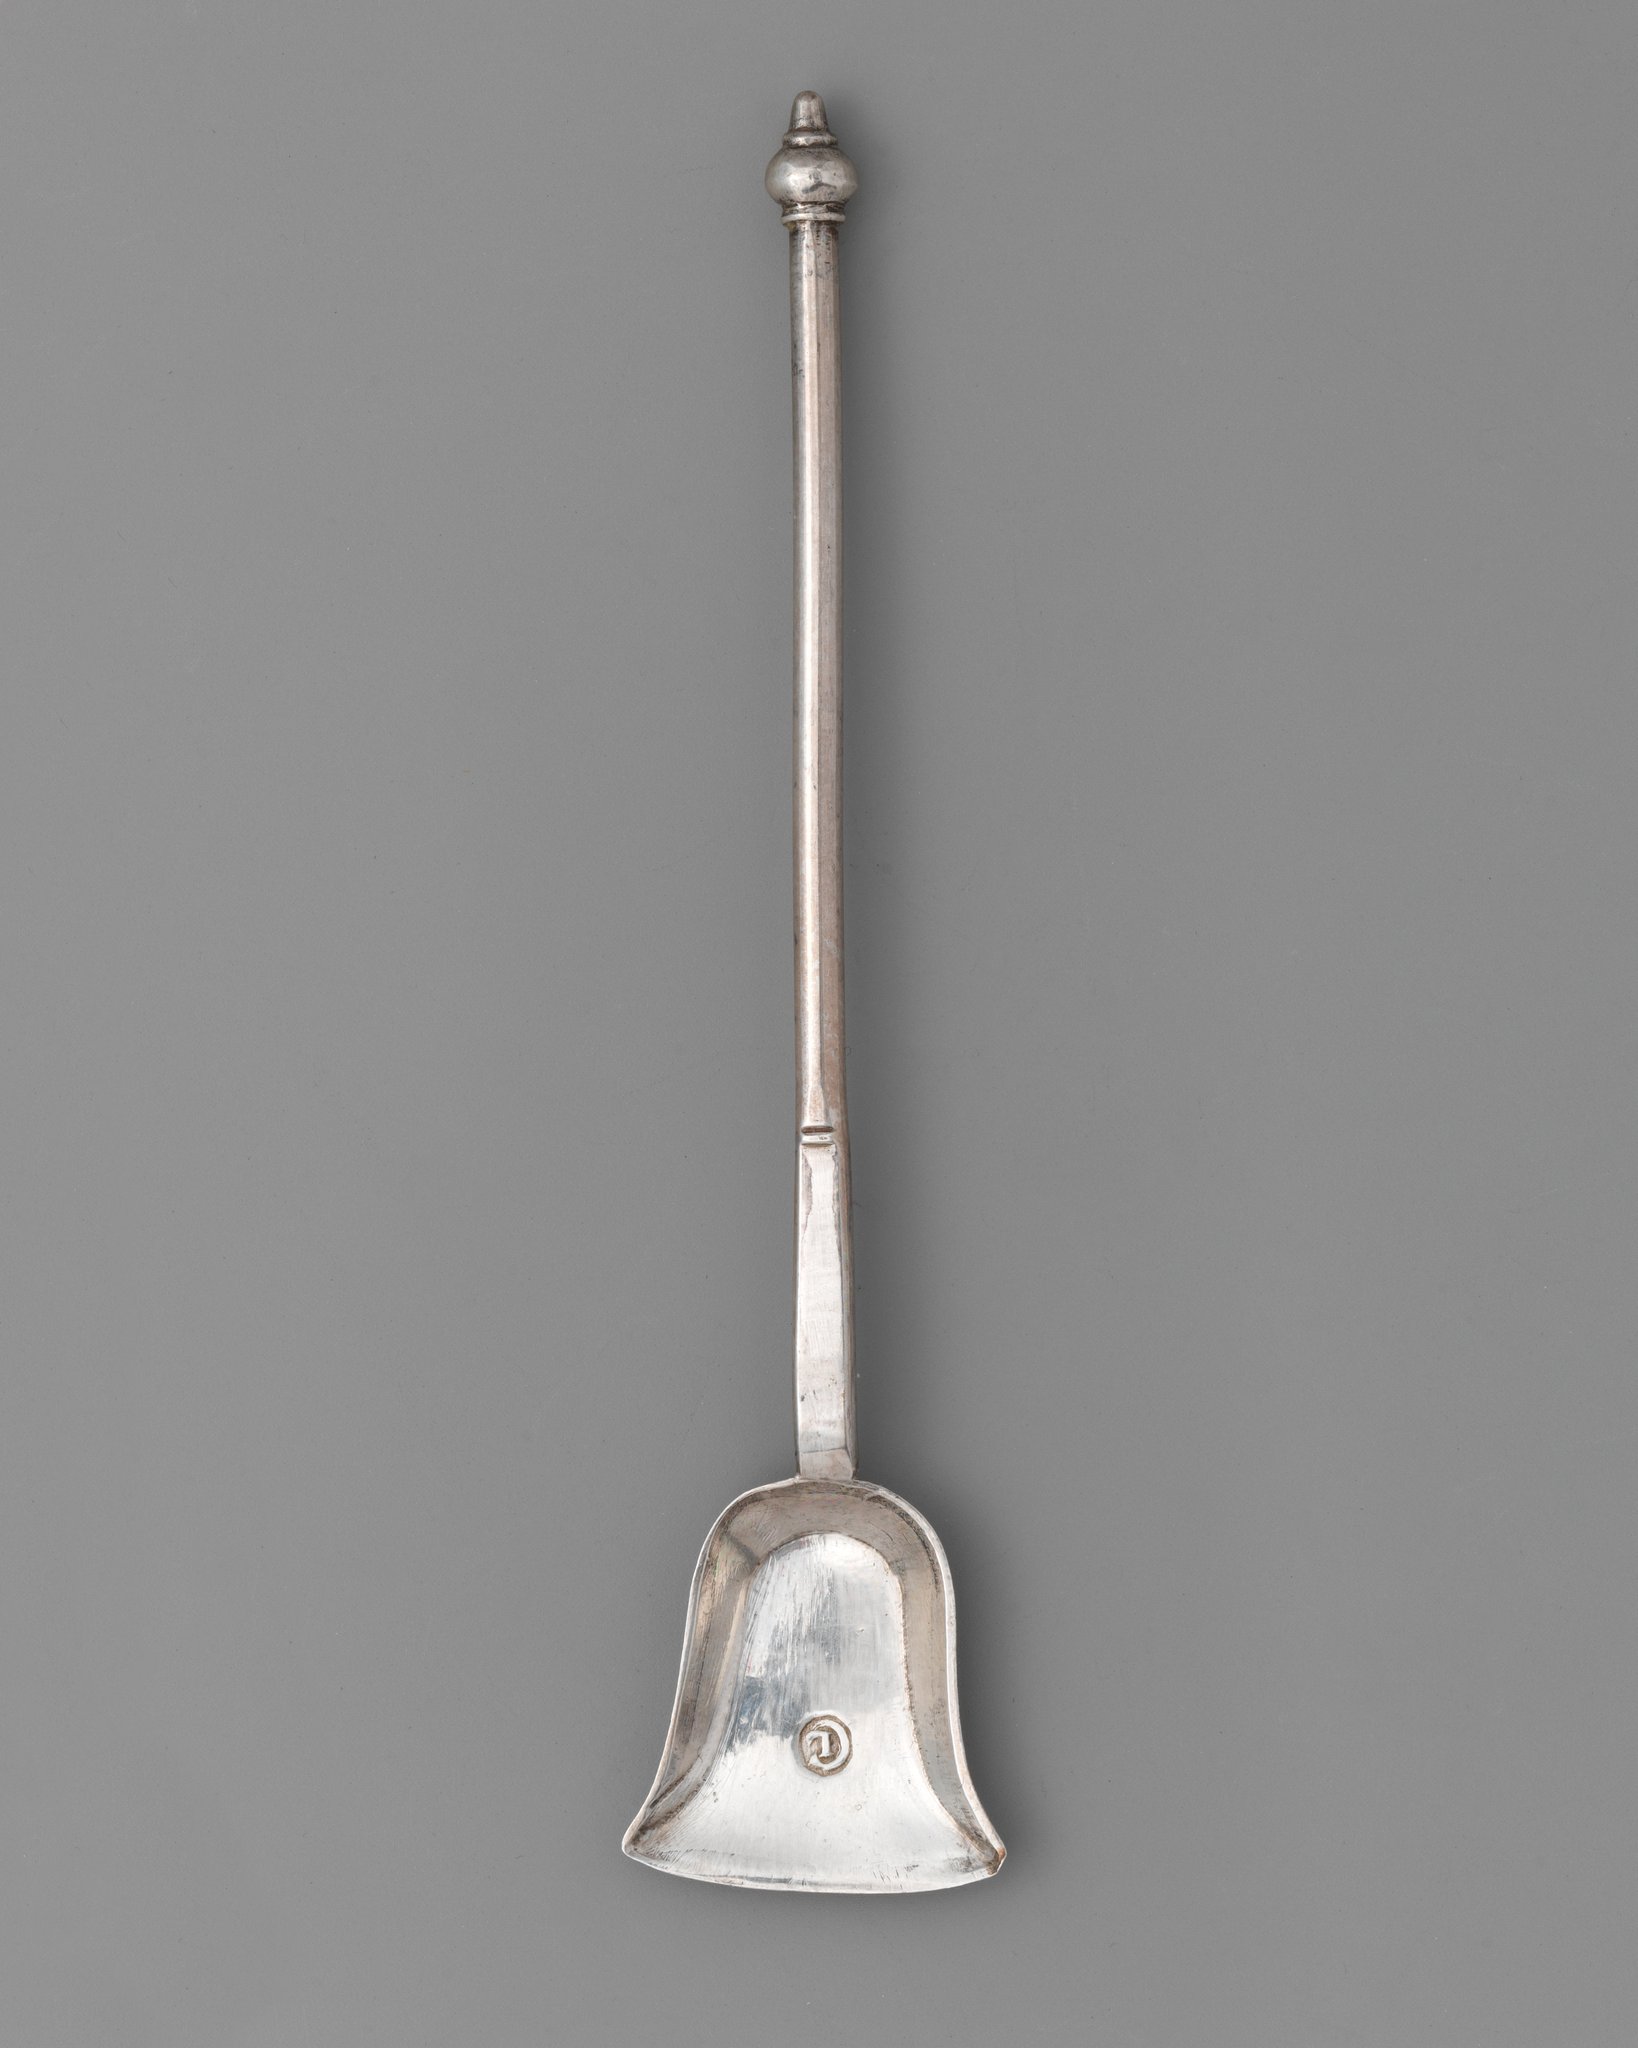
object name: shovel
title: Miniature shovel (part of a set)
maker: david clayton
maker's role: artist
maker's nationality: british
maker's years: 1659-1719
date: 1720-1730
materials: silver